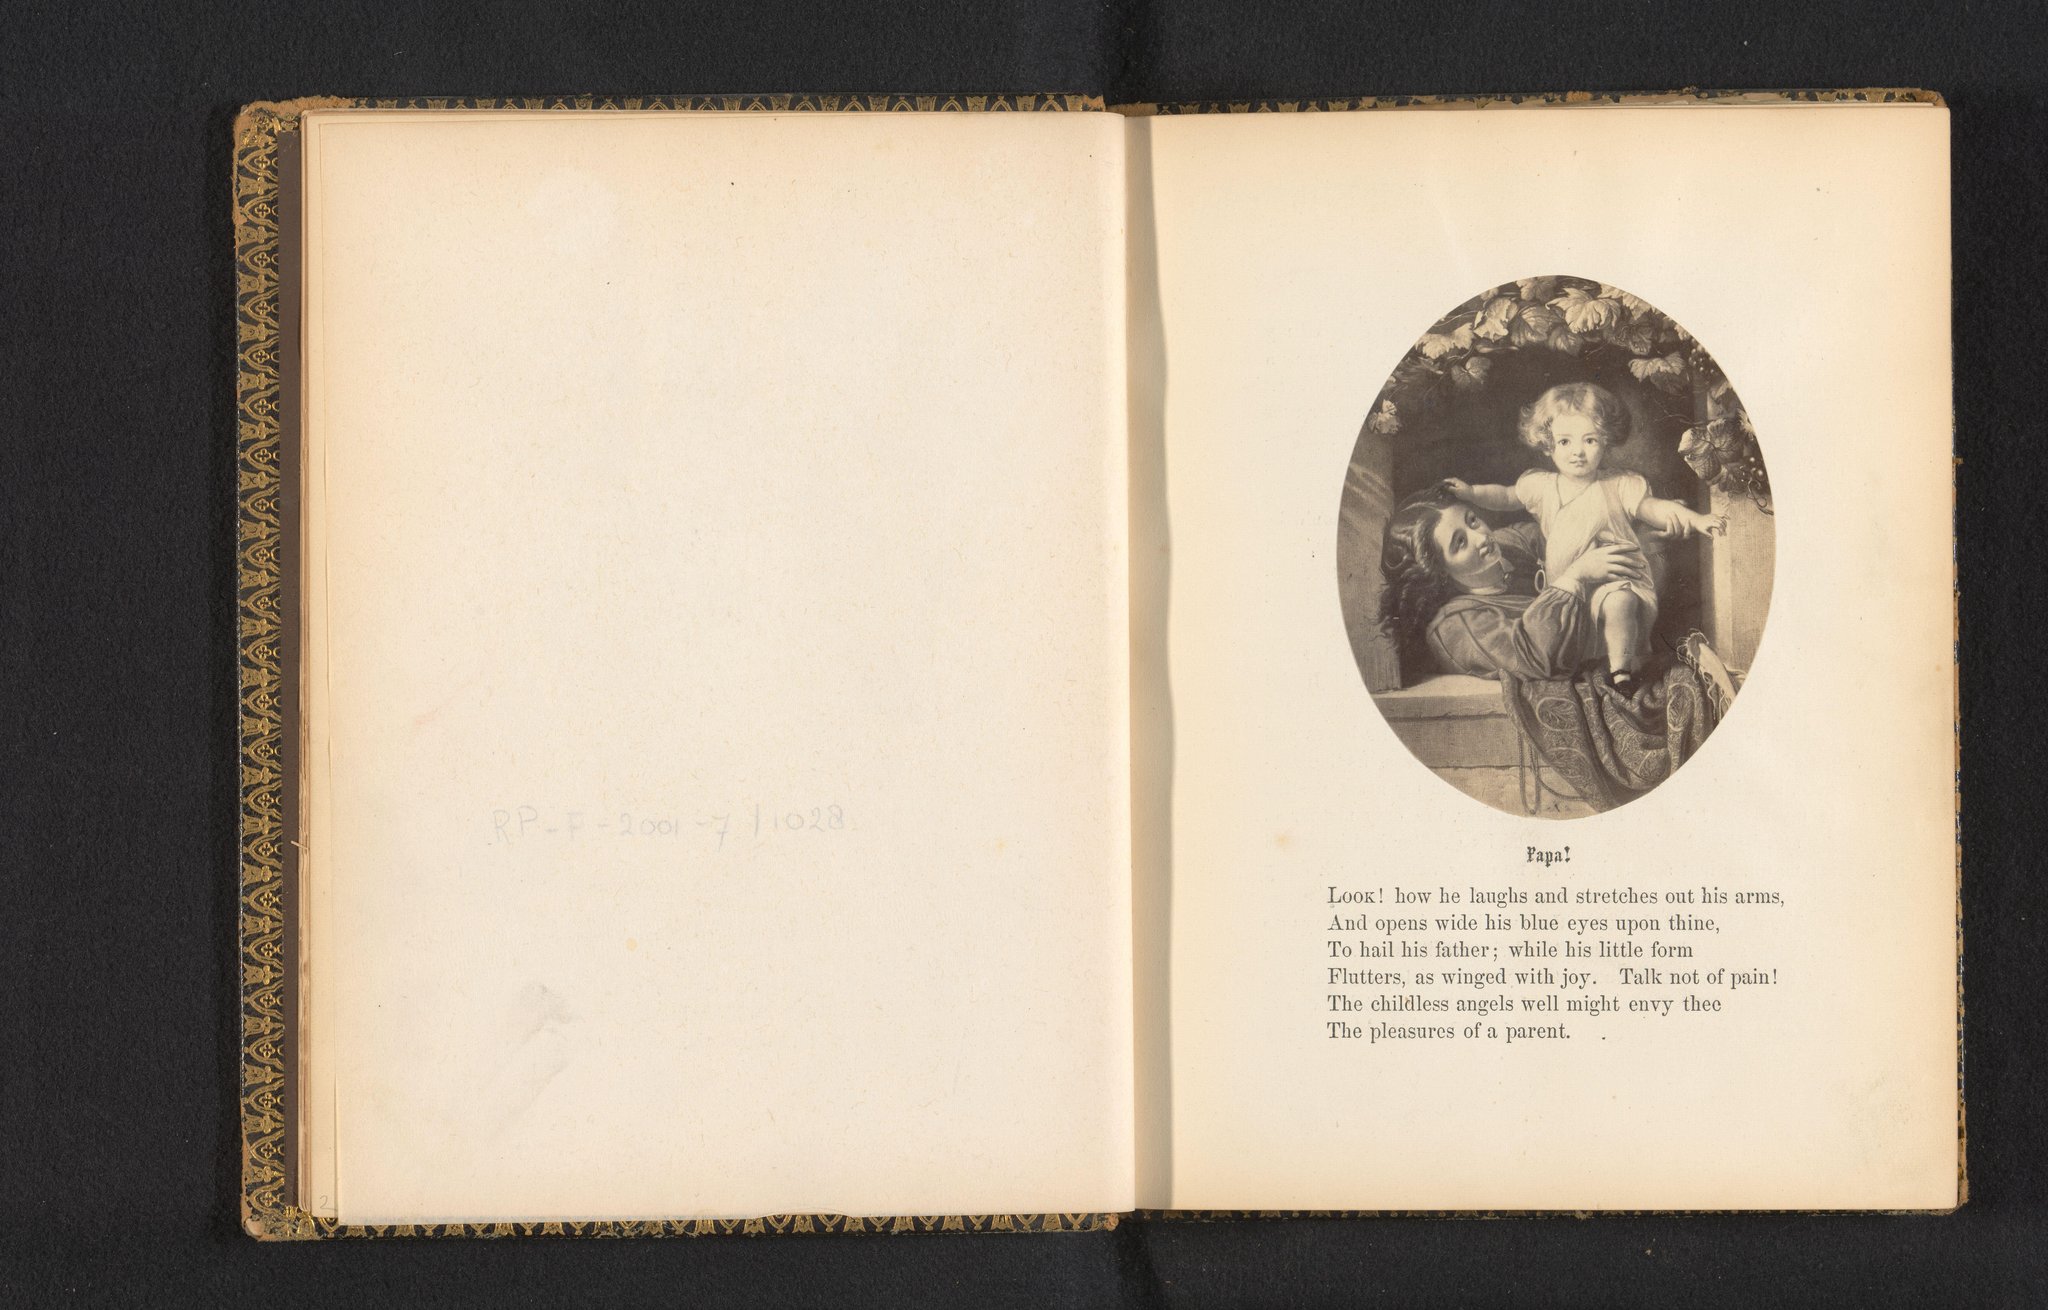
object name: reproduction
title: Papa!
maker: Anonymous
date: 1860-1865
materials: photographic support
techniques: albumen print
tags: window, mother and baby or young child